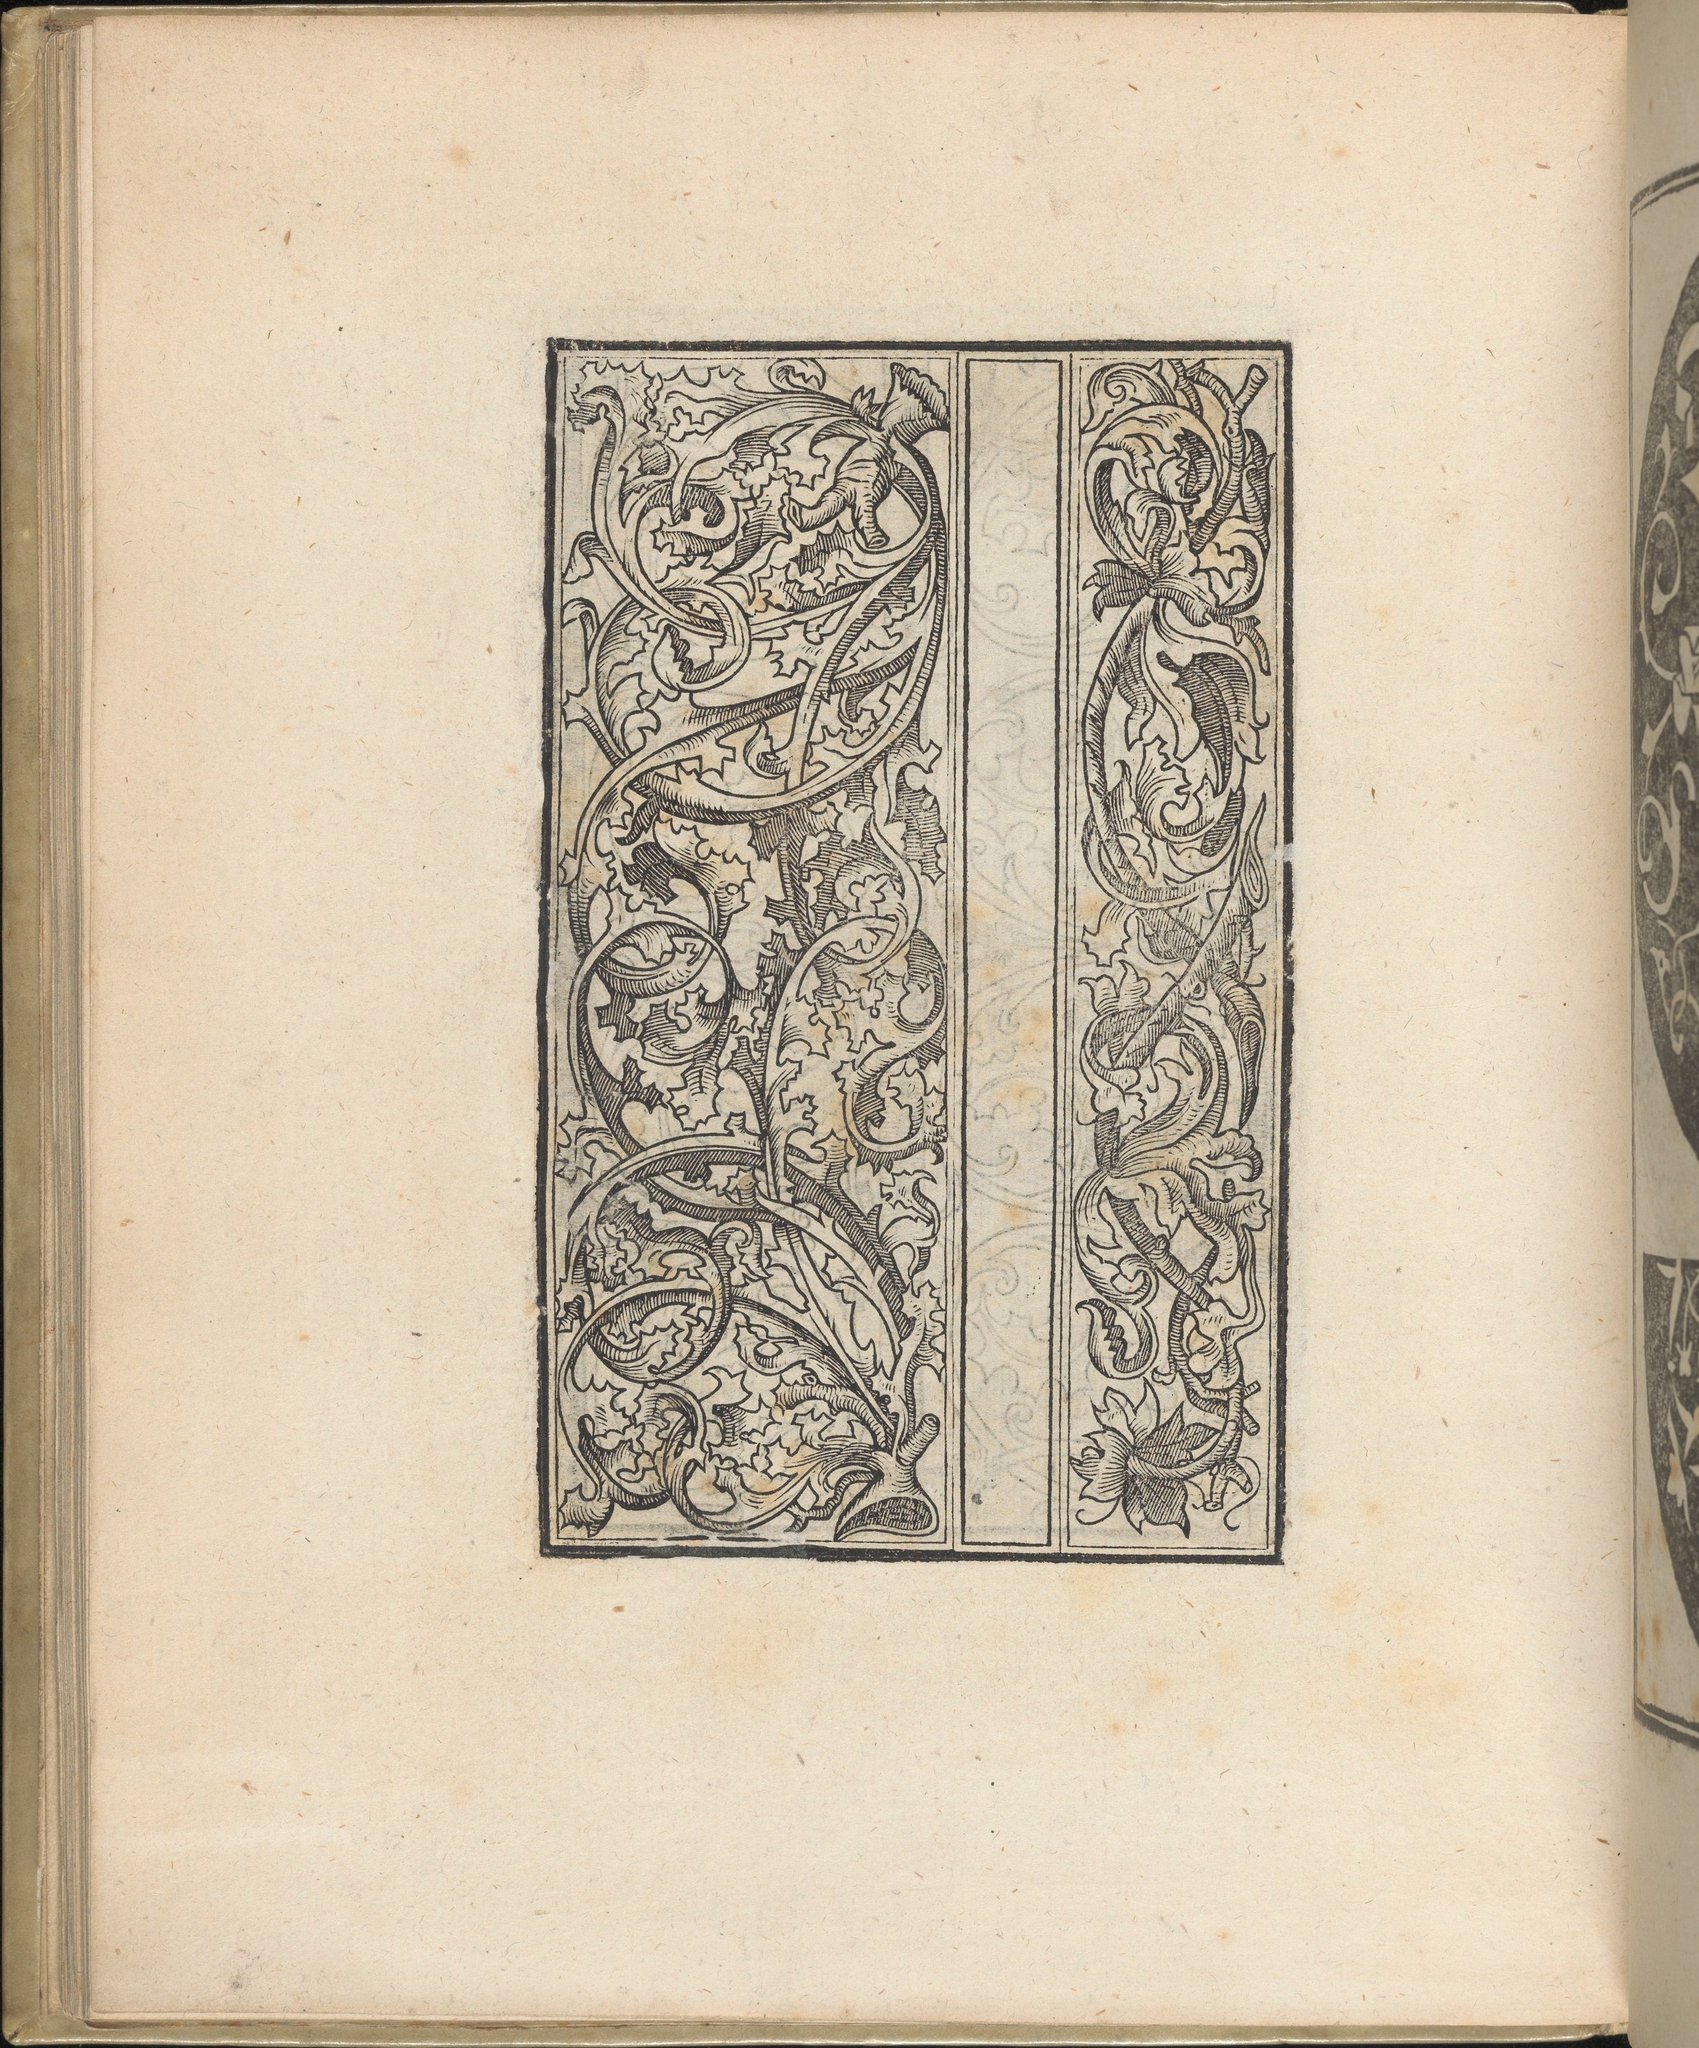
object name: book print ornament architecture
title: Trionfo Di Virtu. Libro Novo..., page 29 (recto)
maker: matteo pagano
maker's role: publisher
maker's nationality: italian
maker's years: 1515-1588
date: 1563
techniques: woodcut